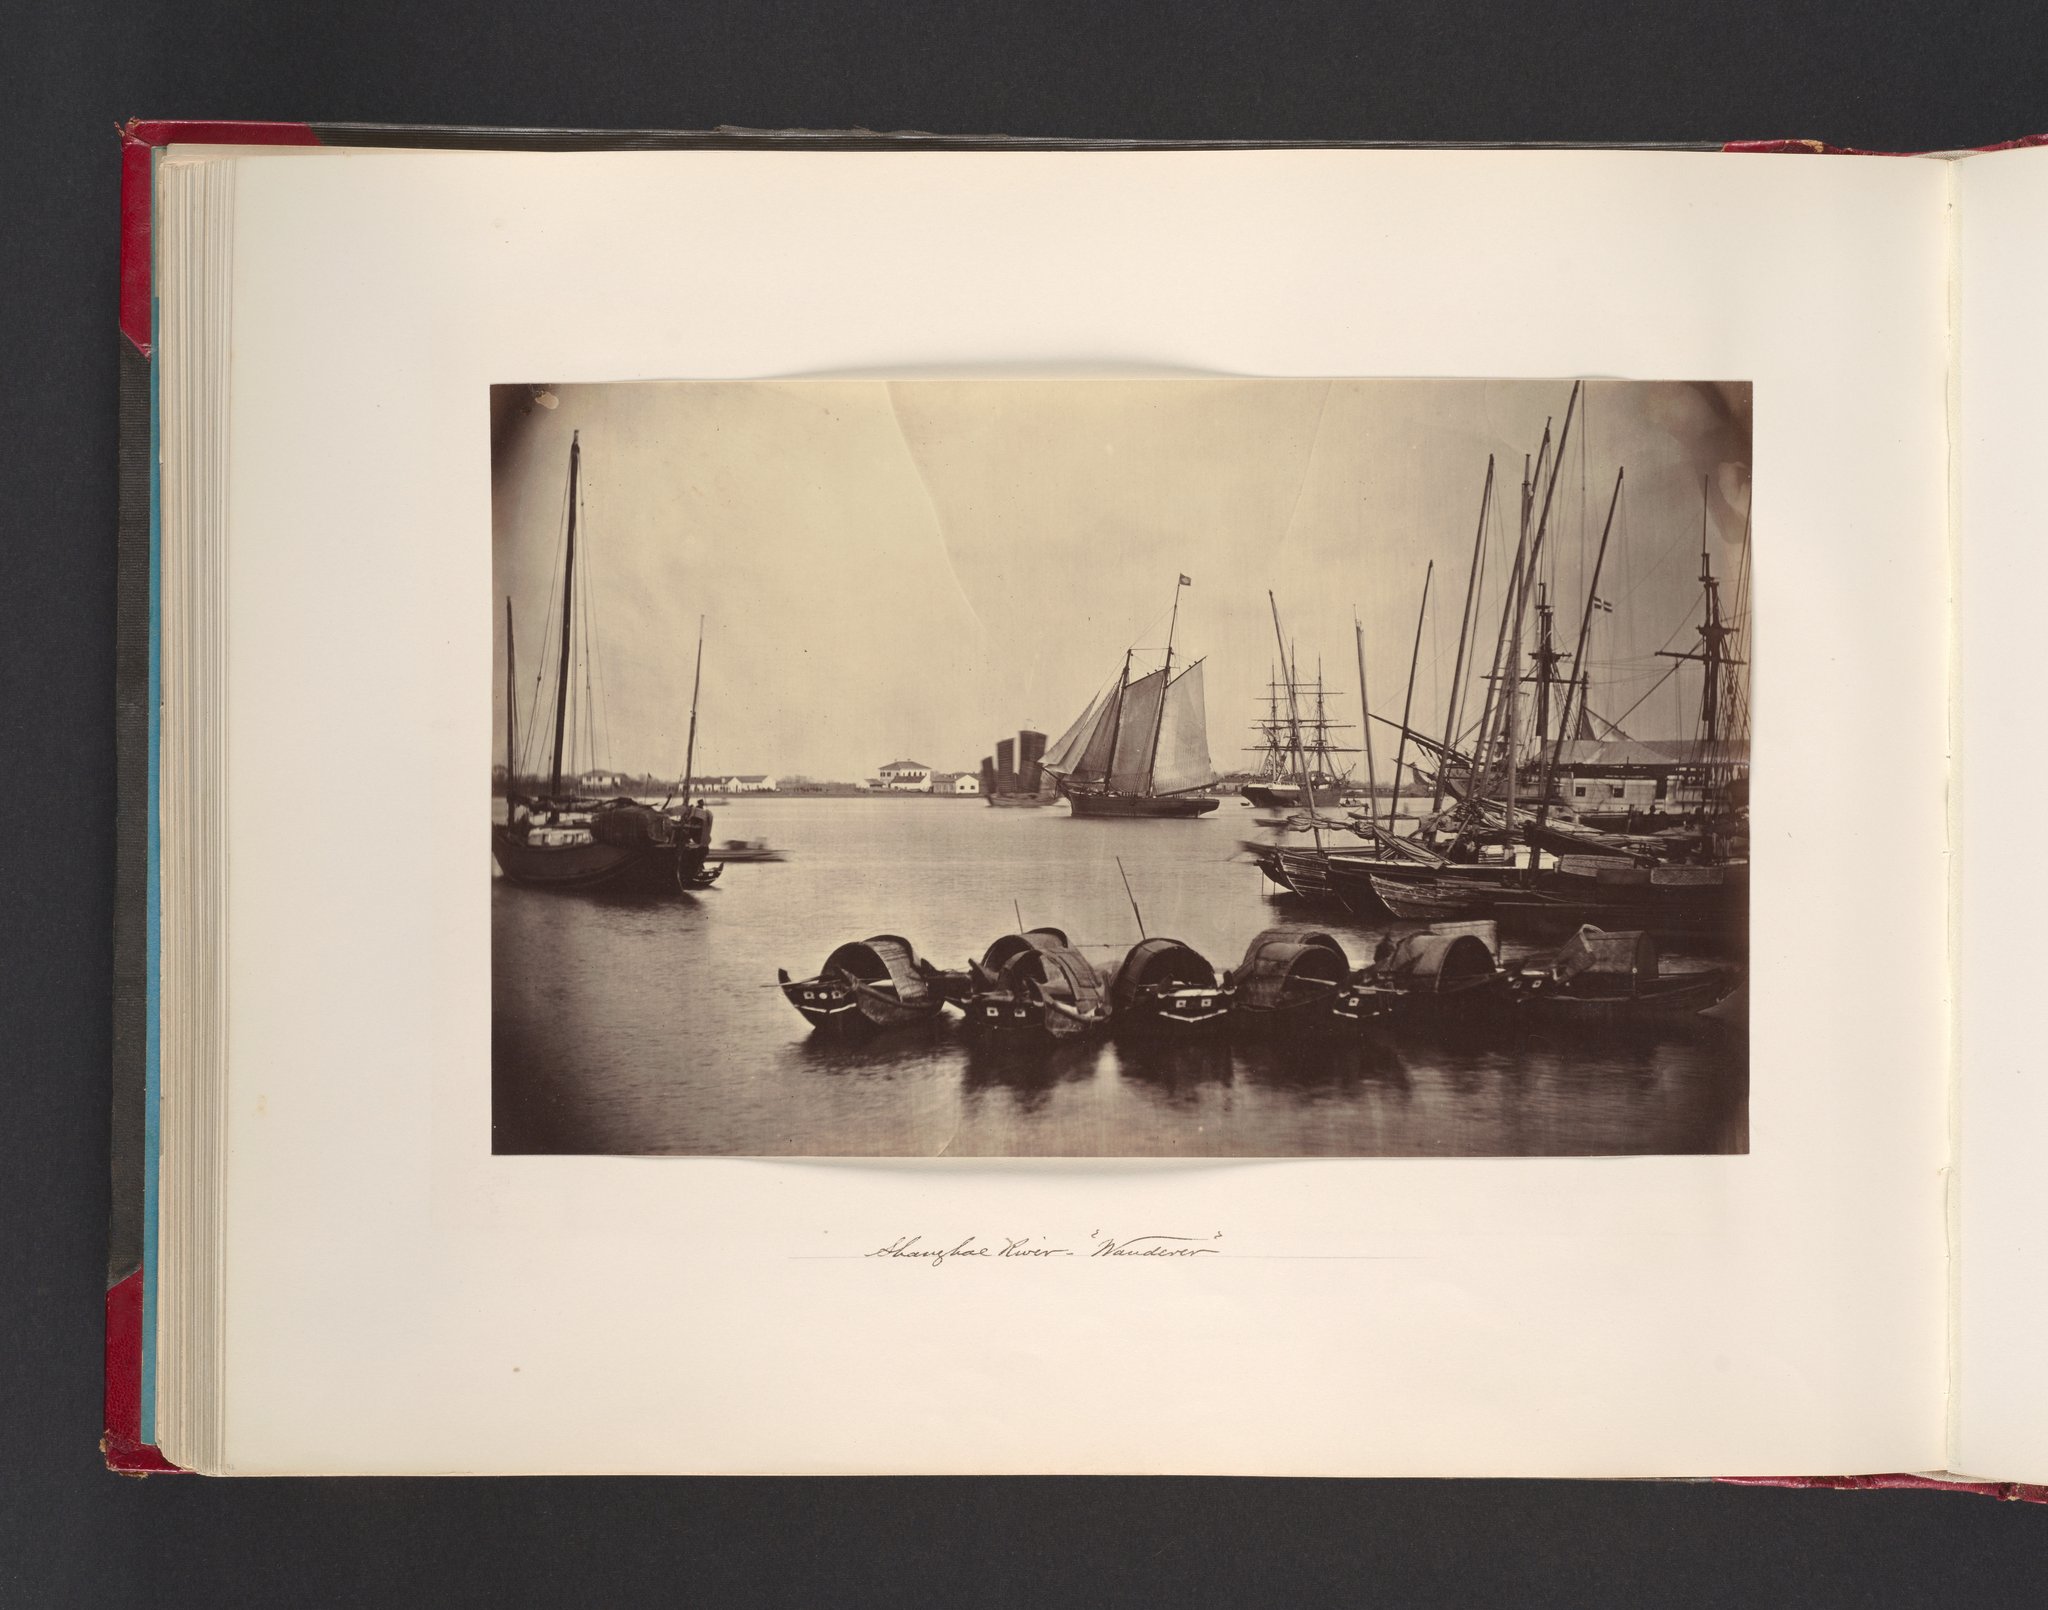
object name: photograph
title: Shanghai River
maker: john thomson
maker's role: artist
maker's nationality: british, scottish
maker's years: 1837-1921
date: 1865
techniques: albumen silver print, glass negative